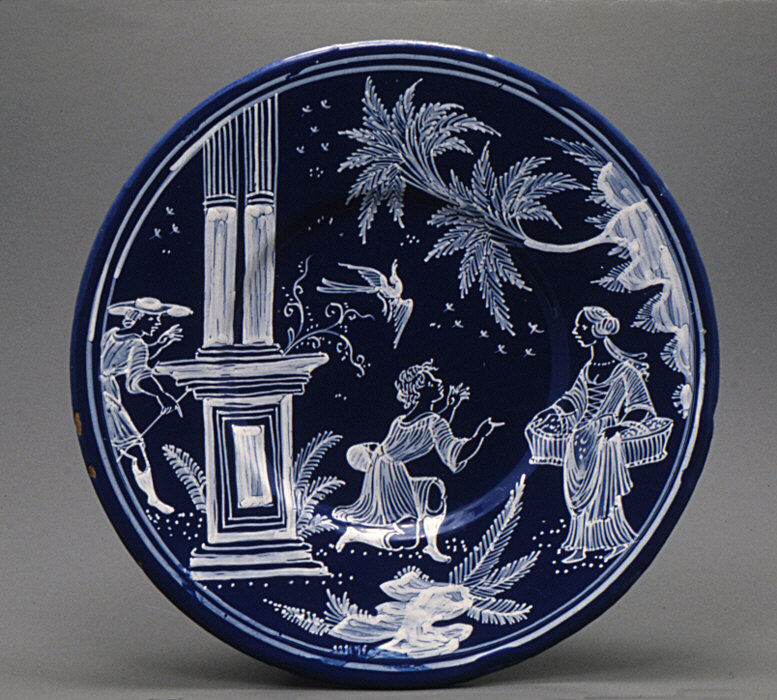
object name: plate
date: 1675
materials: faience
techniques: glazing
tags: birds,men,women,trees